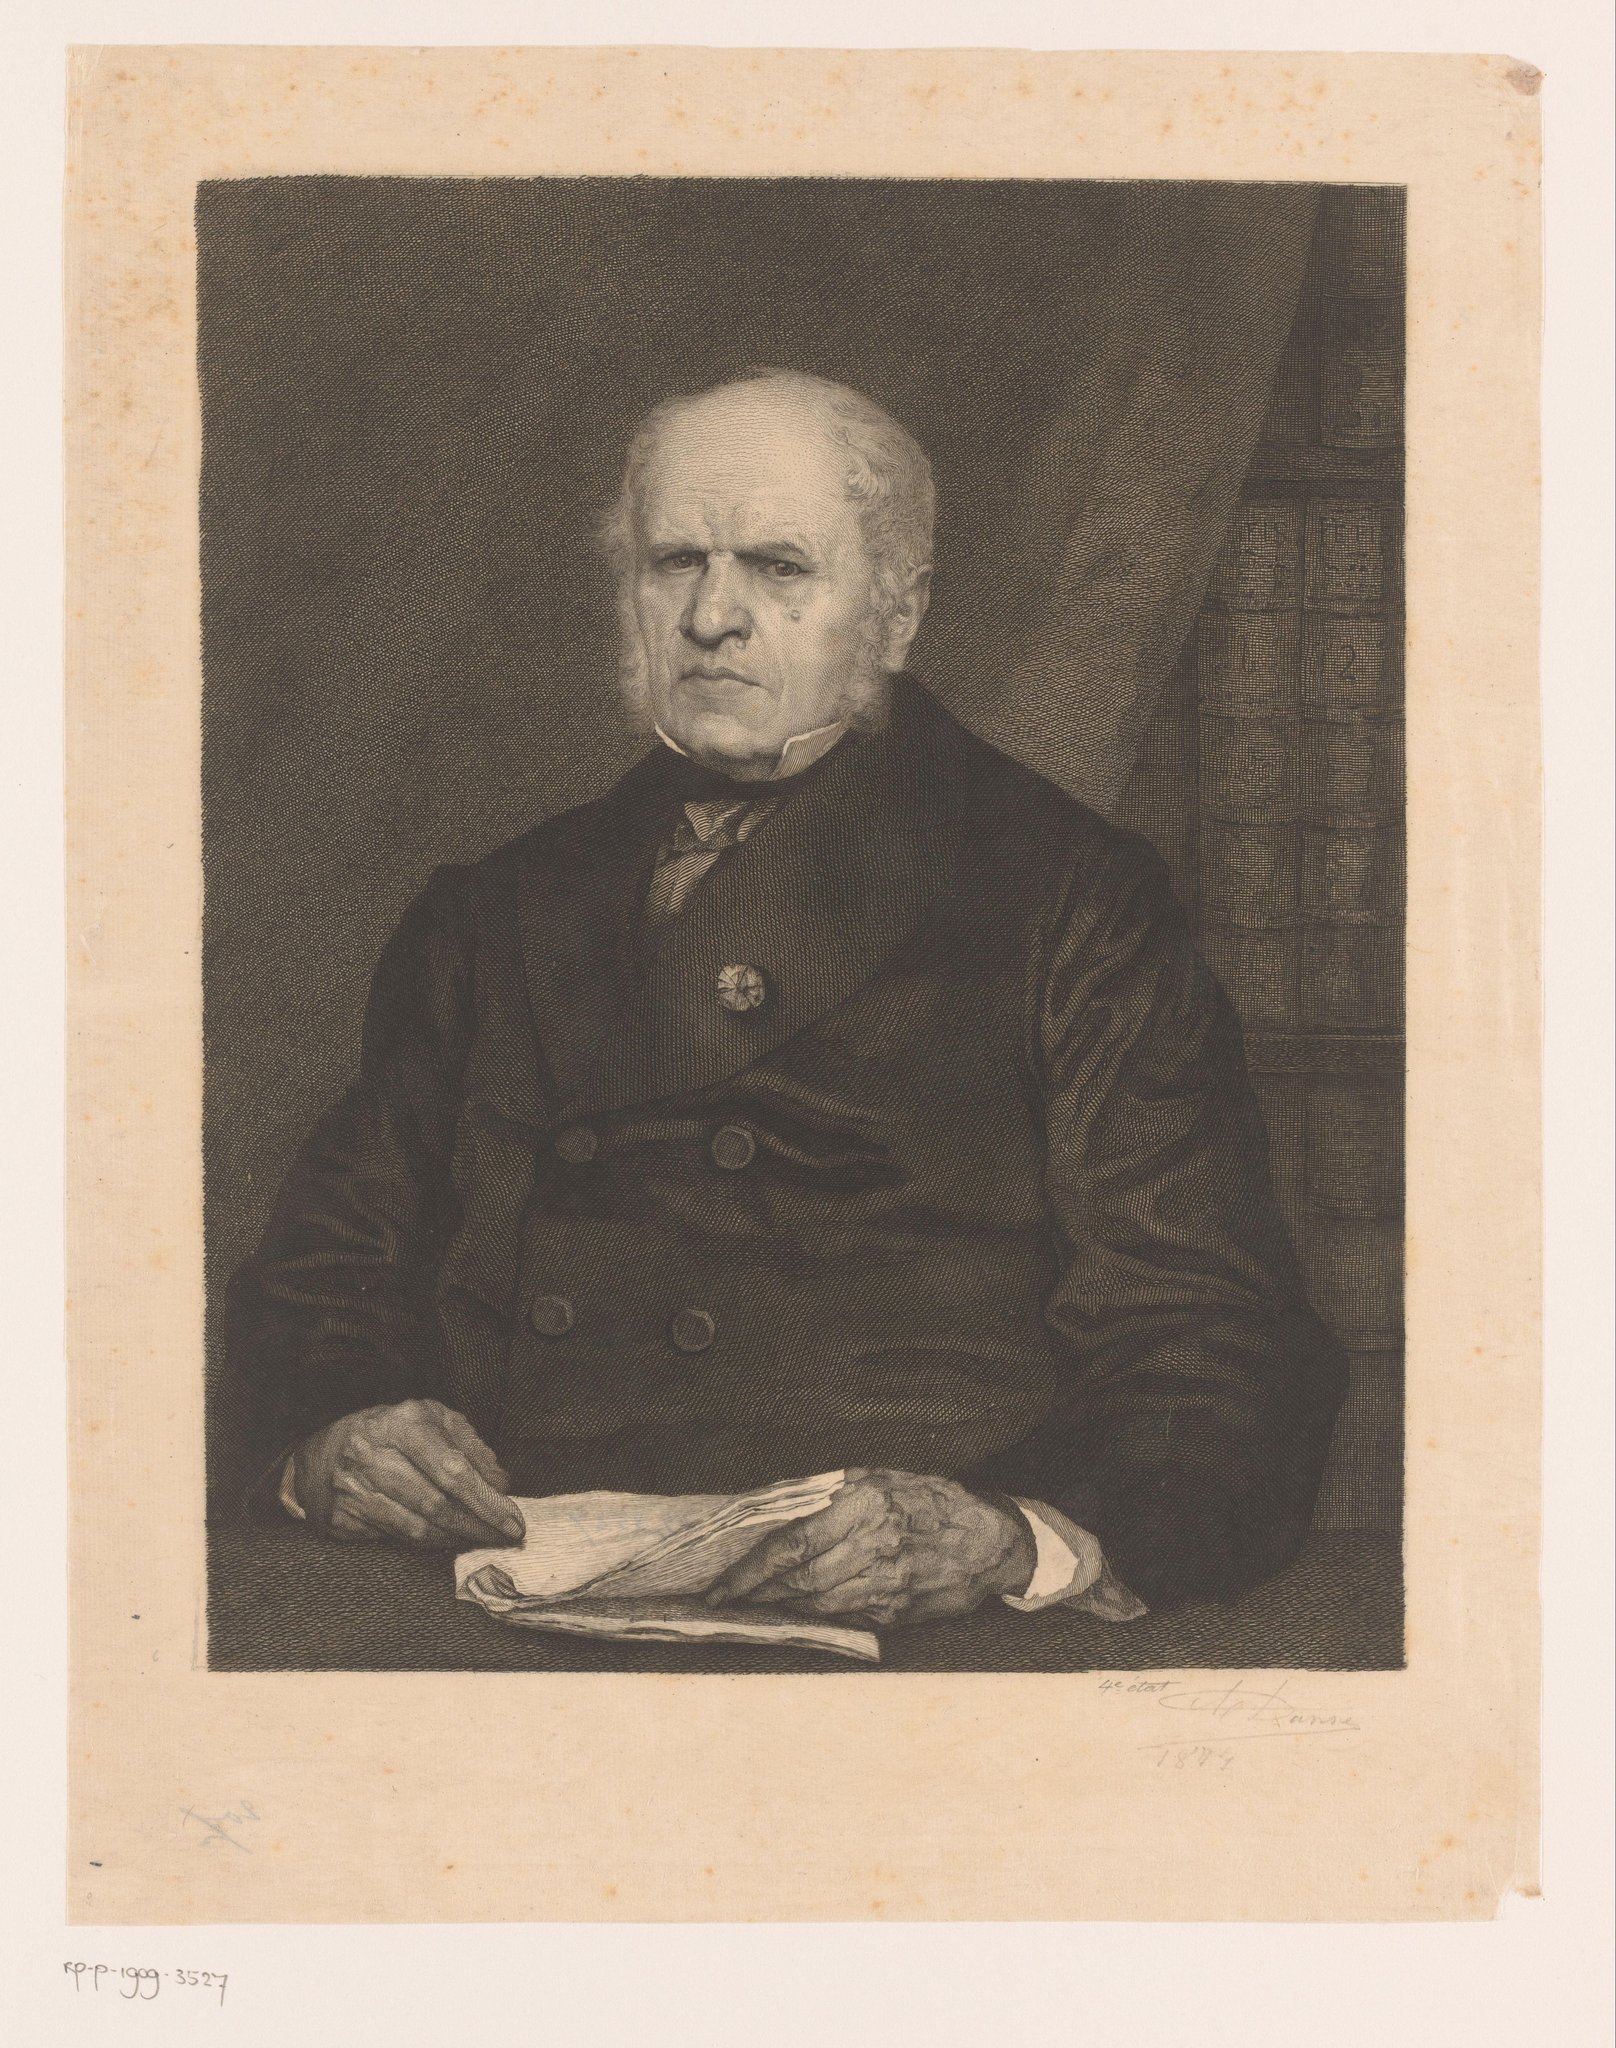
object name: print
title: Portret van Édouard Fétis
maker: auguste danse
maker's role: print maker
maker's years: 1829-1929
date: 1874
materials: paper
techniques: engraving, etching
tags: brussels, édouard fétis, historical person (...) - historical person (...) portrayed alone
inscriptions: annotation: ‘4e état’, collector's mark: Lugt 2228